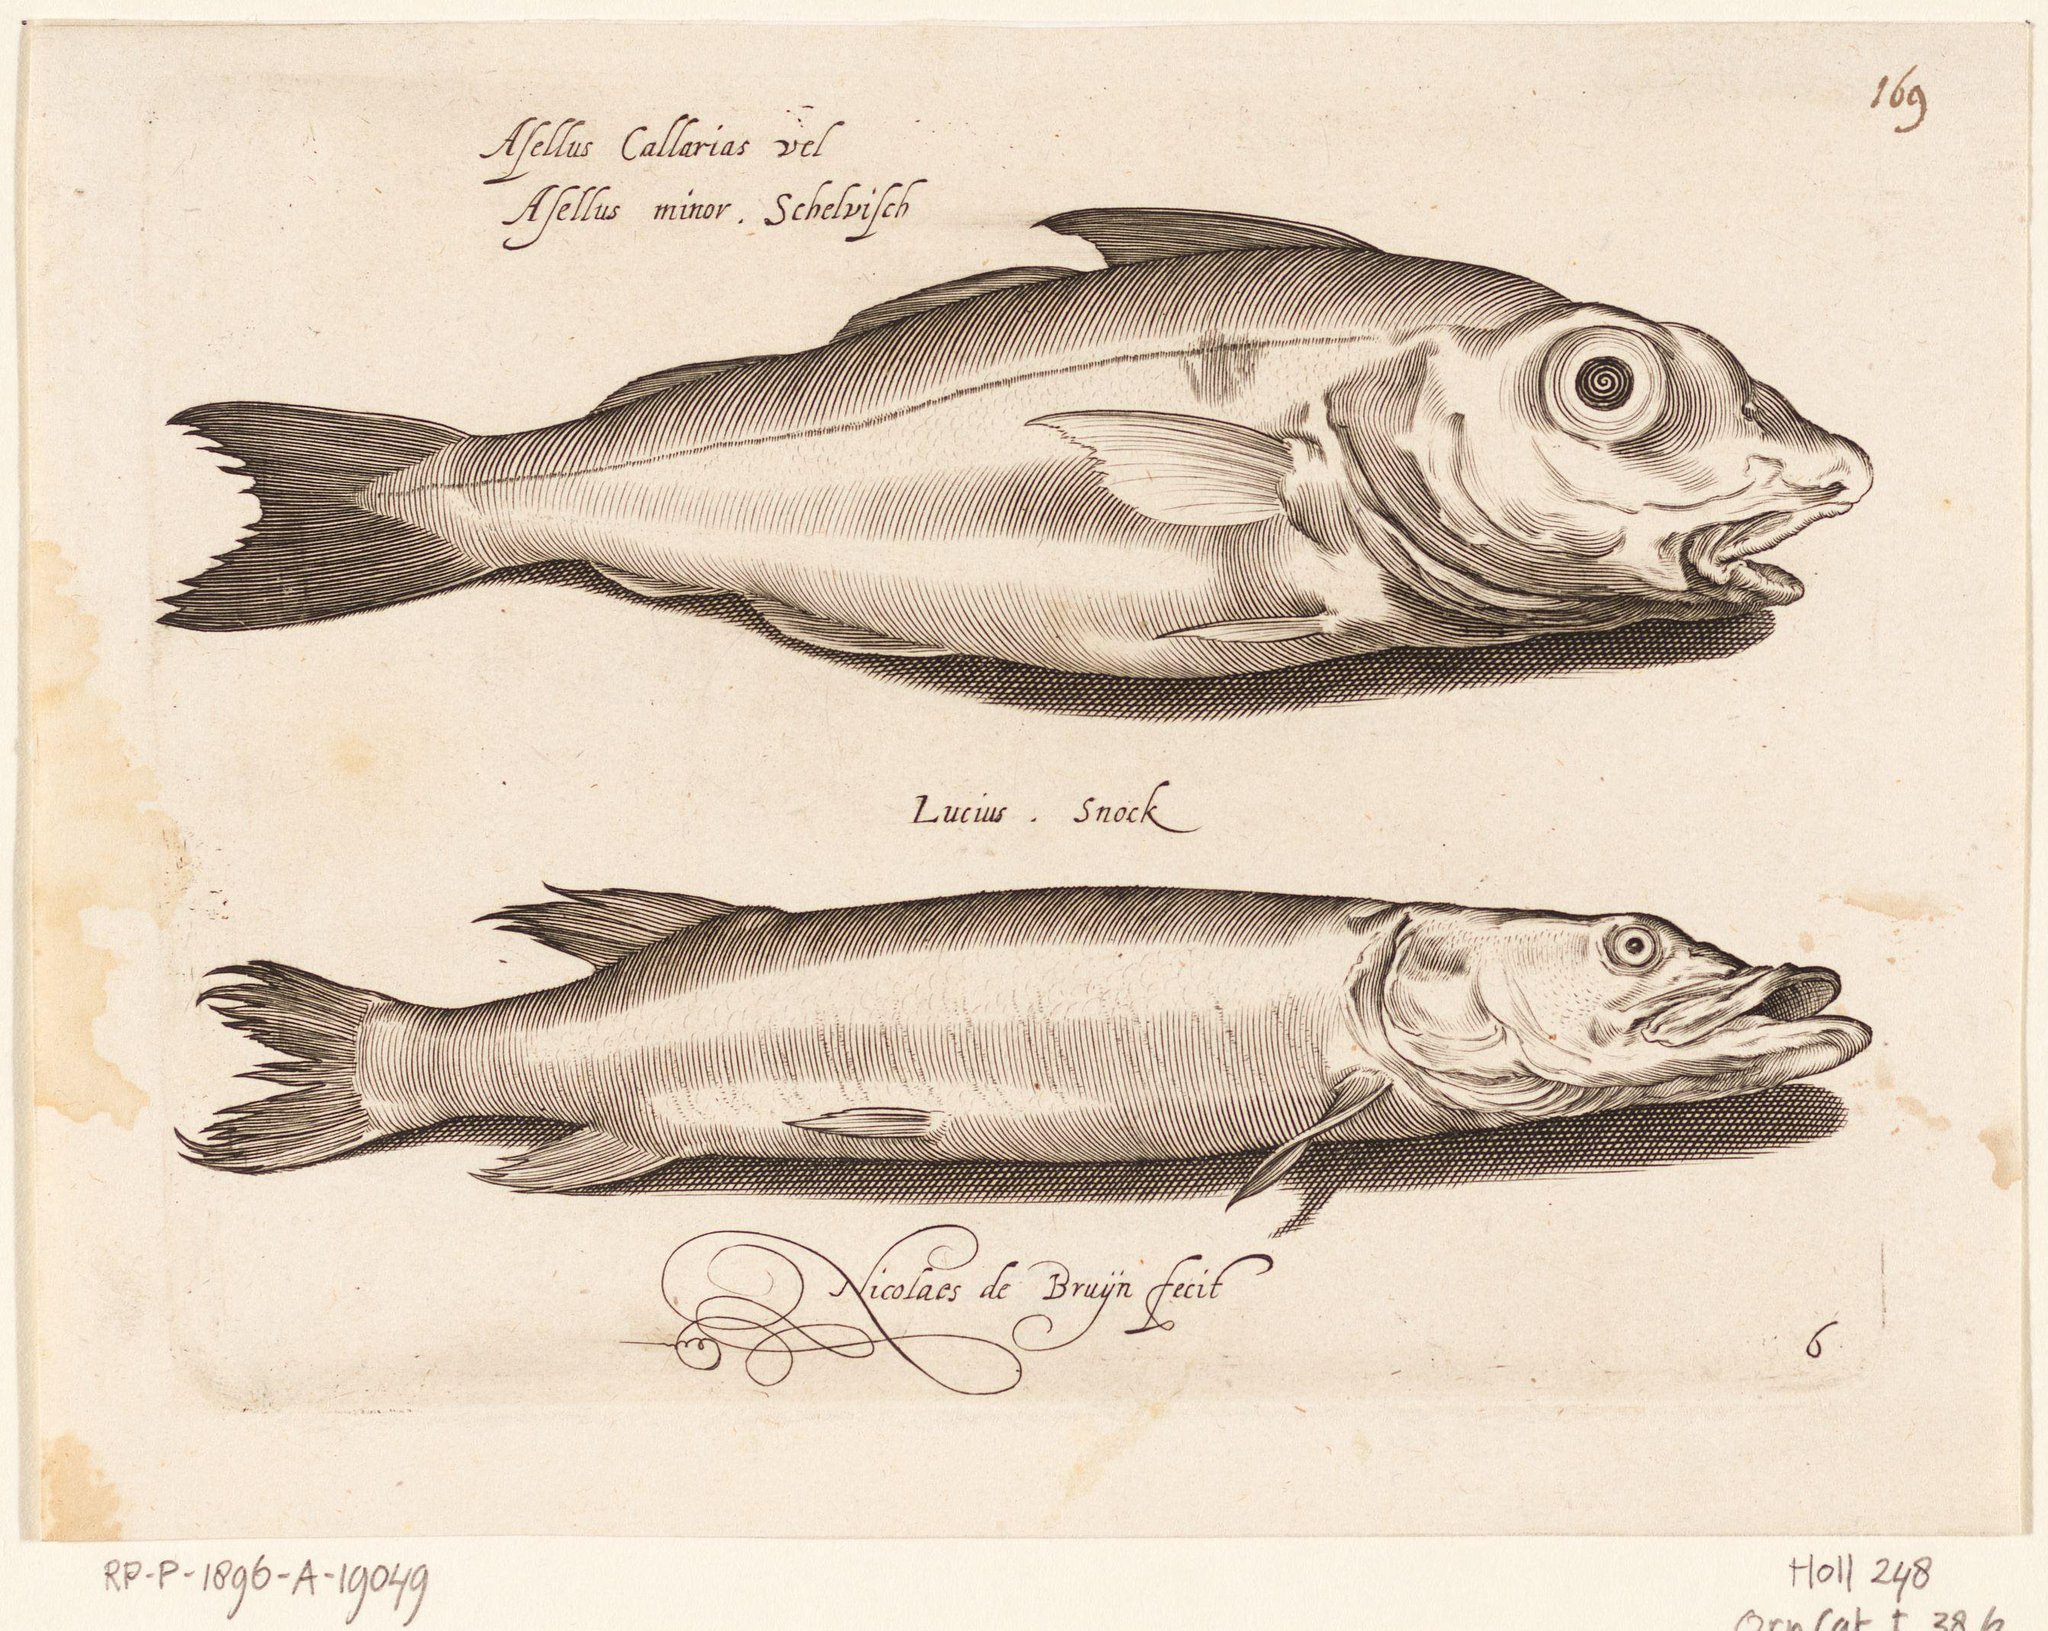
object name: print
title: Schelvis en snoek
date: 1581-1656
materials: paper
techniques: engraving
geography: netherlands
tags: birds, bony fishes: pike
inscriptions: collector's mark: Lugt 2228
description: Prent uit serie Libelivs varia Genera piscium complectens van dertien prenten met zoetwatervissen, zeevissen, kikkers, schaaldieren en zeewezens (inclusief titelprent). Vermoedelijk ging een uitgave van Assuerus van Londerseel vooraf aan deze editie van Francoys van Beusekom, zie De Groot 1988, p. 38.